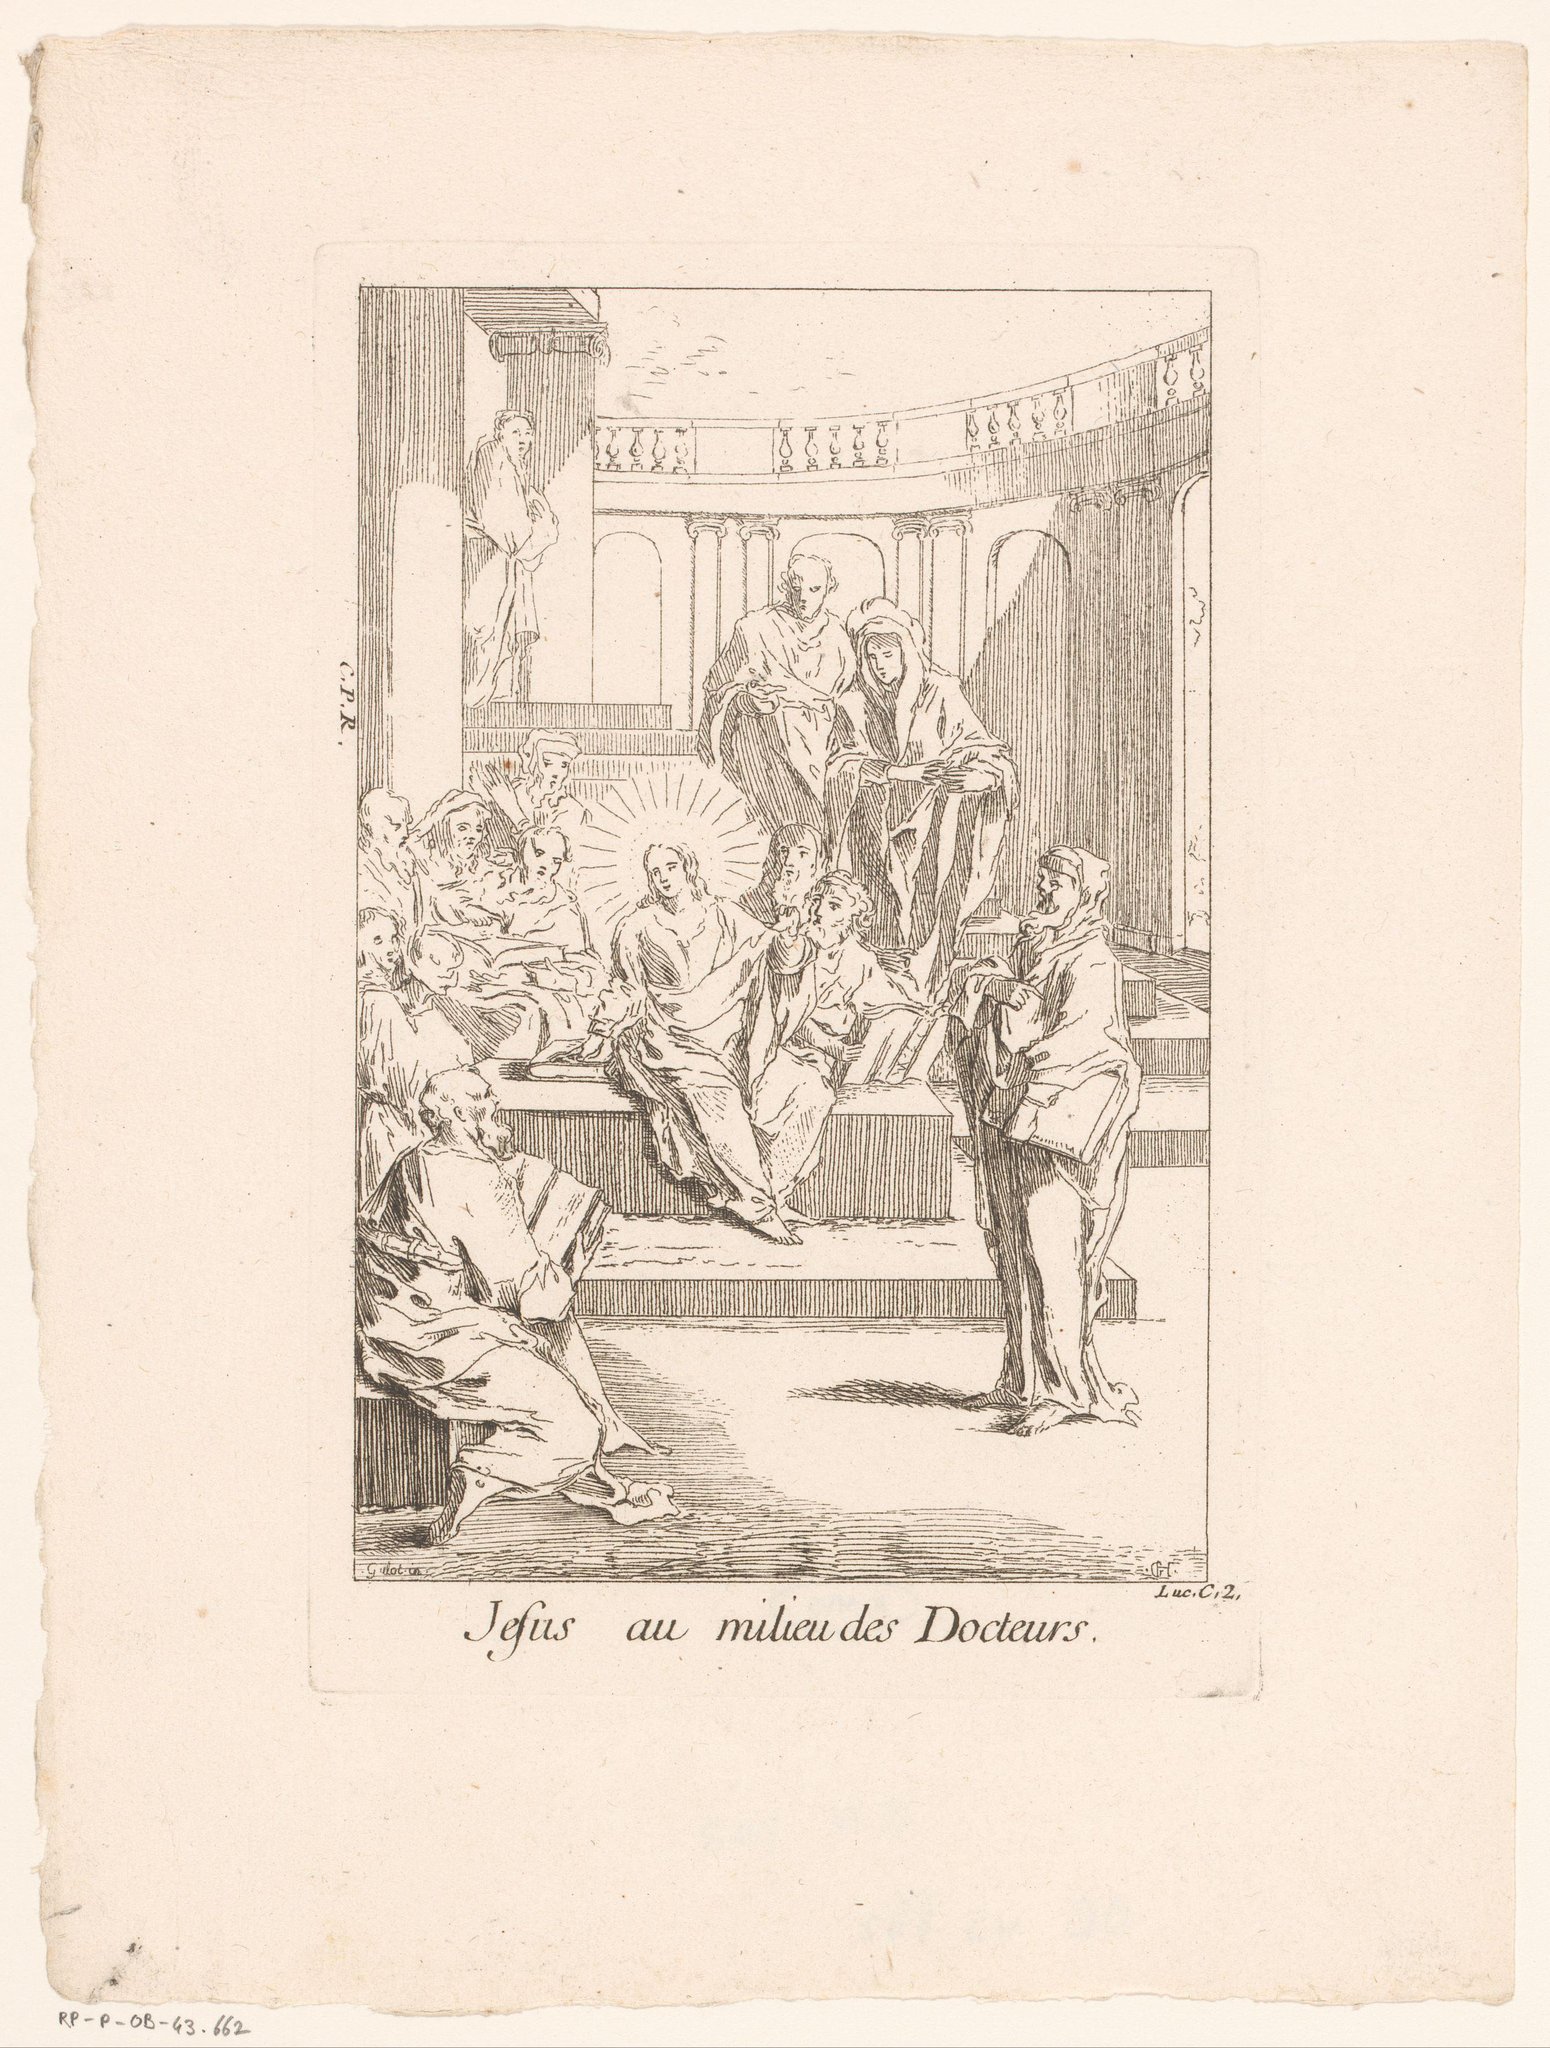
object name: print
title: La Vie de N.S. Jesus C.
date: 1705-1732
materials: paper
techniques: etching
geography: paris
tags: christ's dispute with the doctors in the temple; he counts his arguments on his fingers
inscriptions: collector's mark: Lugt 2228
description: Maakt deel uit van een serie met zestig prenten met als thema het leven van Christus.